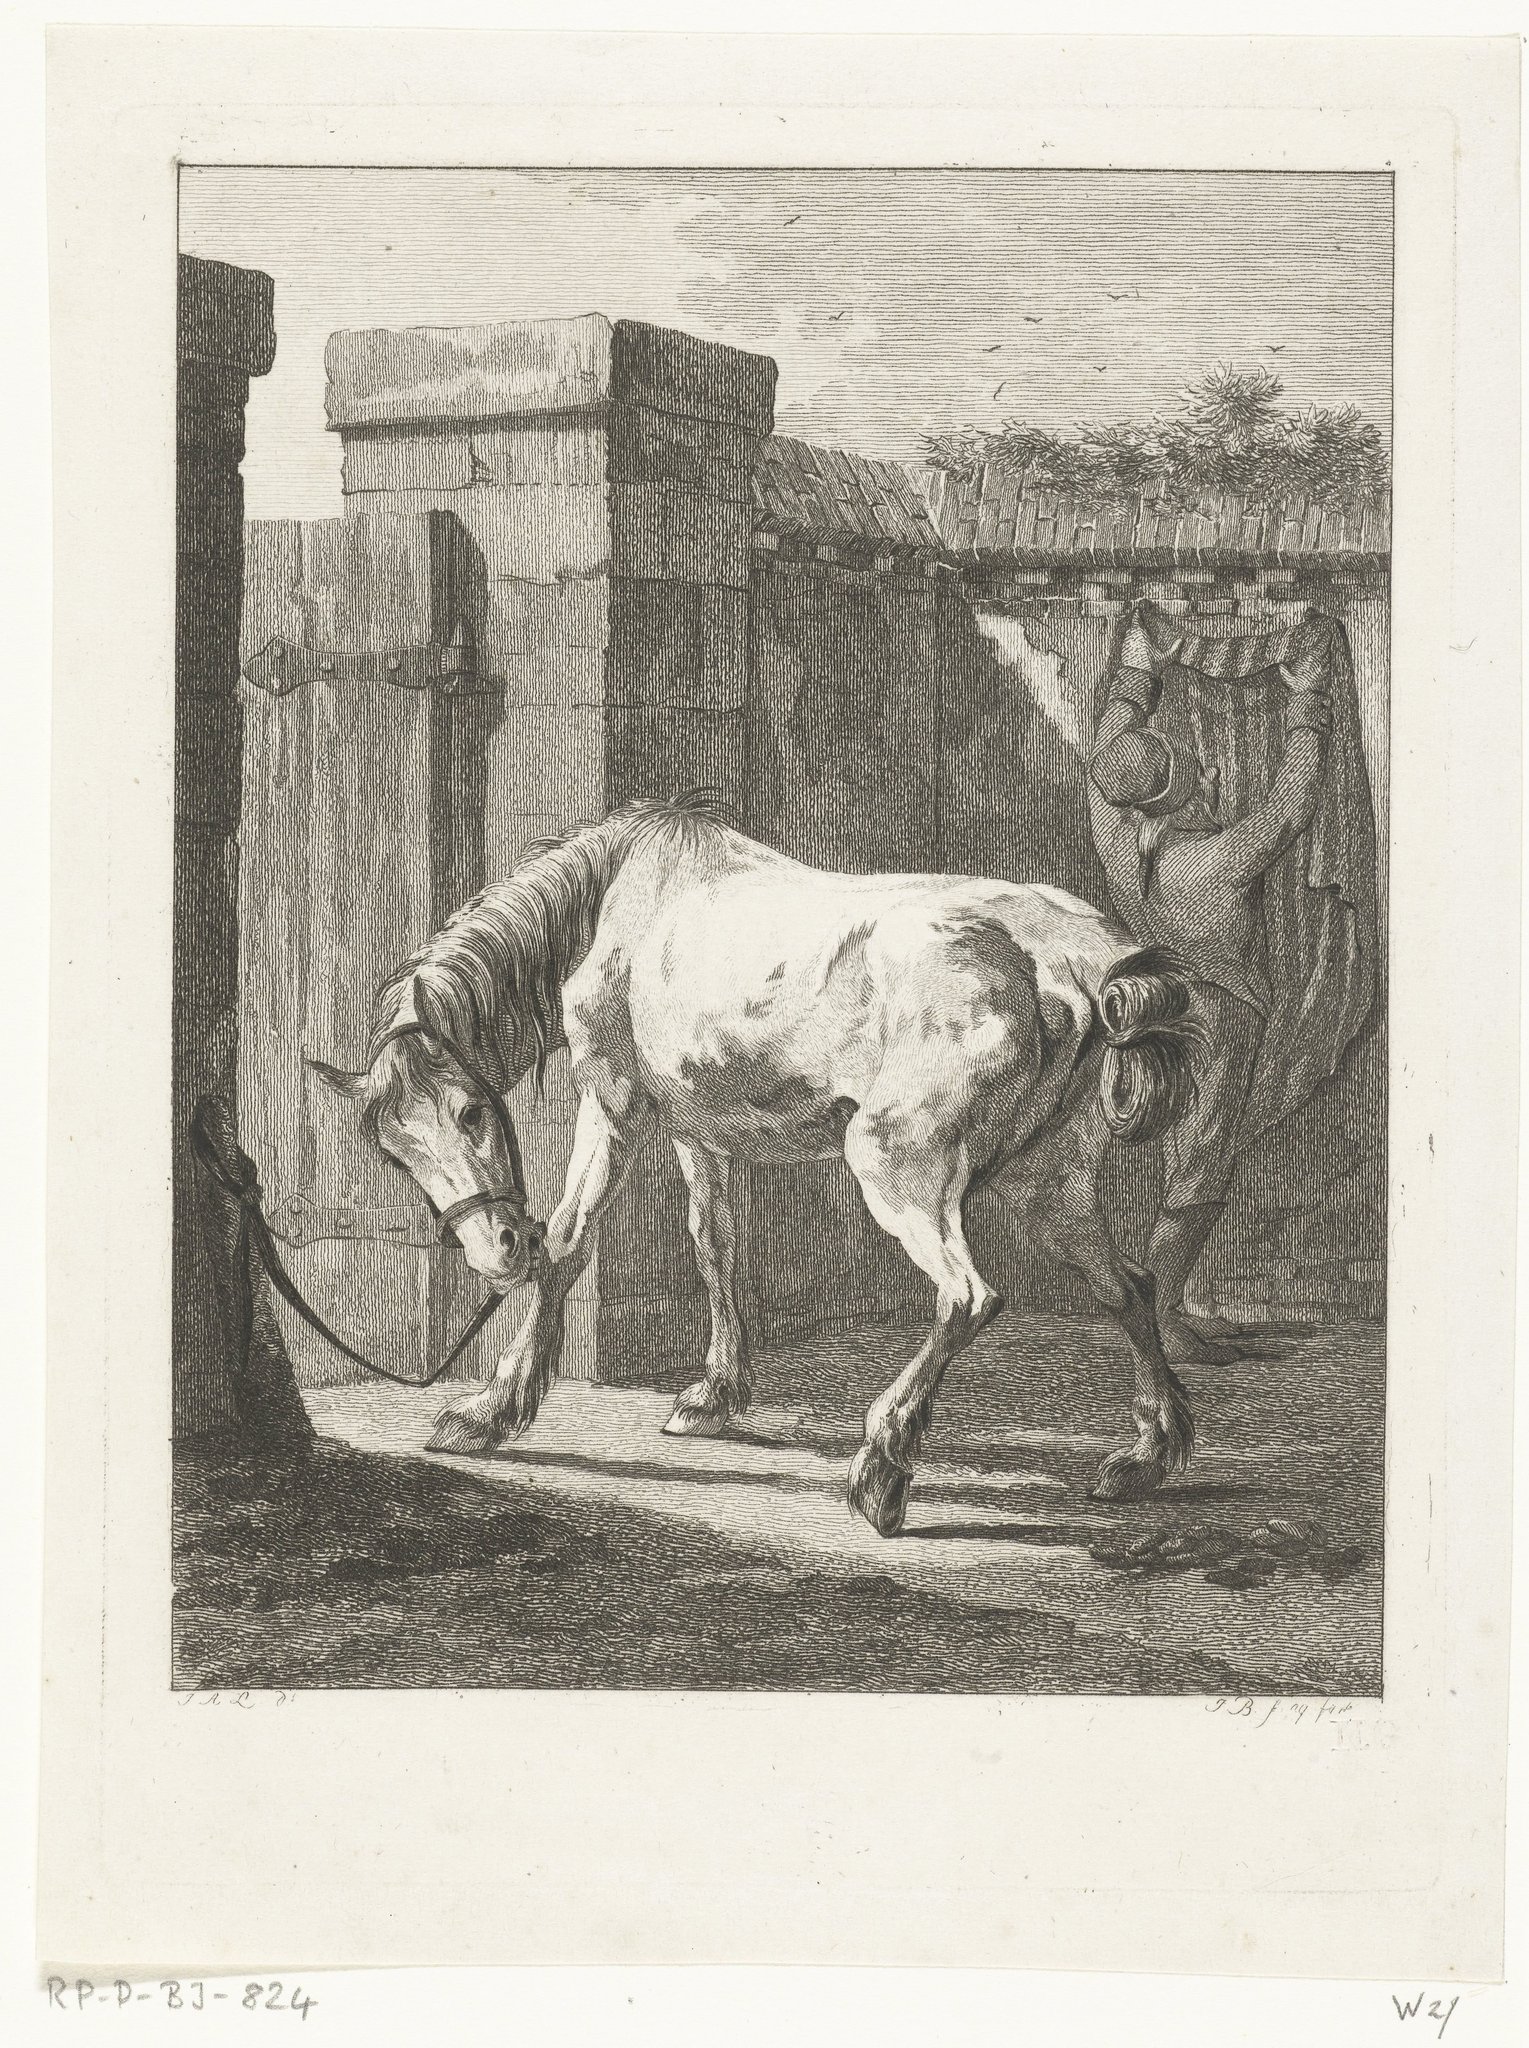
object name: print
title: Paarden met knechten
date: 1802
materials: paper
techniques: etching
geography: rotterdam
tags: horse, occupations ~ cattle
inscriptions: collector's mark: Lugt 2228, collector's mark: Lugt 1967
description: Een paard vastgebonden aan een paal bij een openstaande poortdeur. Het paard heeft een opgebonden staart. Achter het paard een knecht die een deken uitschudt.